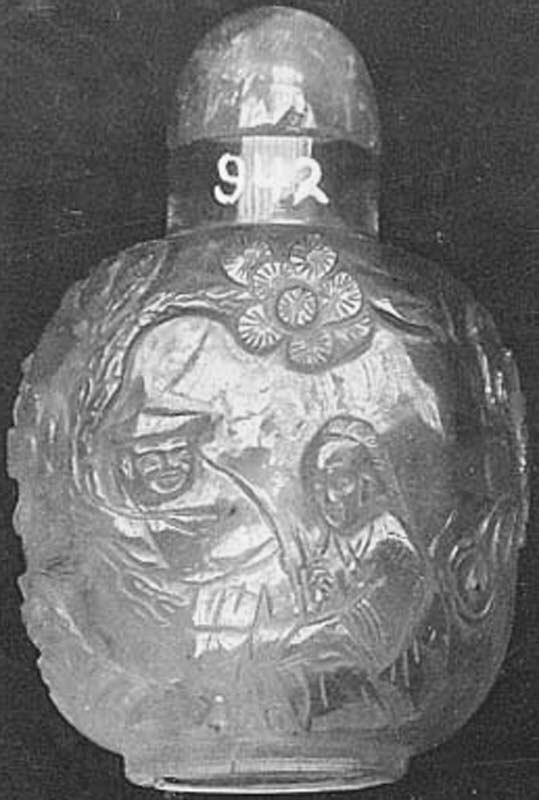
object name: snuff bottle with stopper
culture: chinese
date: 1701-1900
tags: human figures